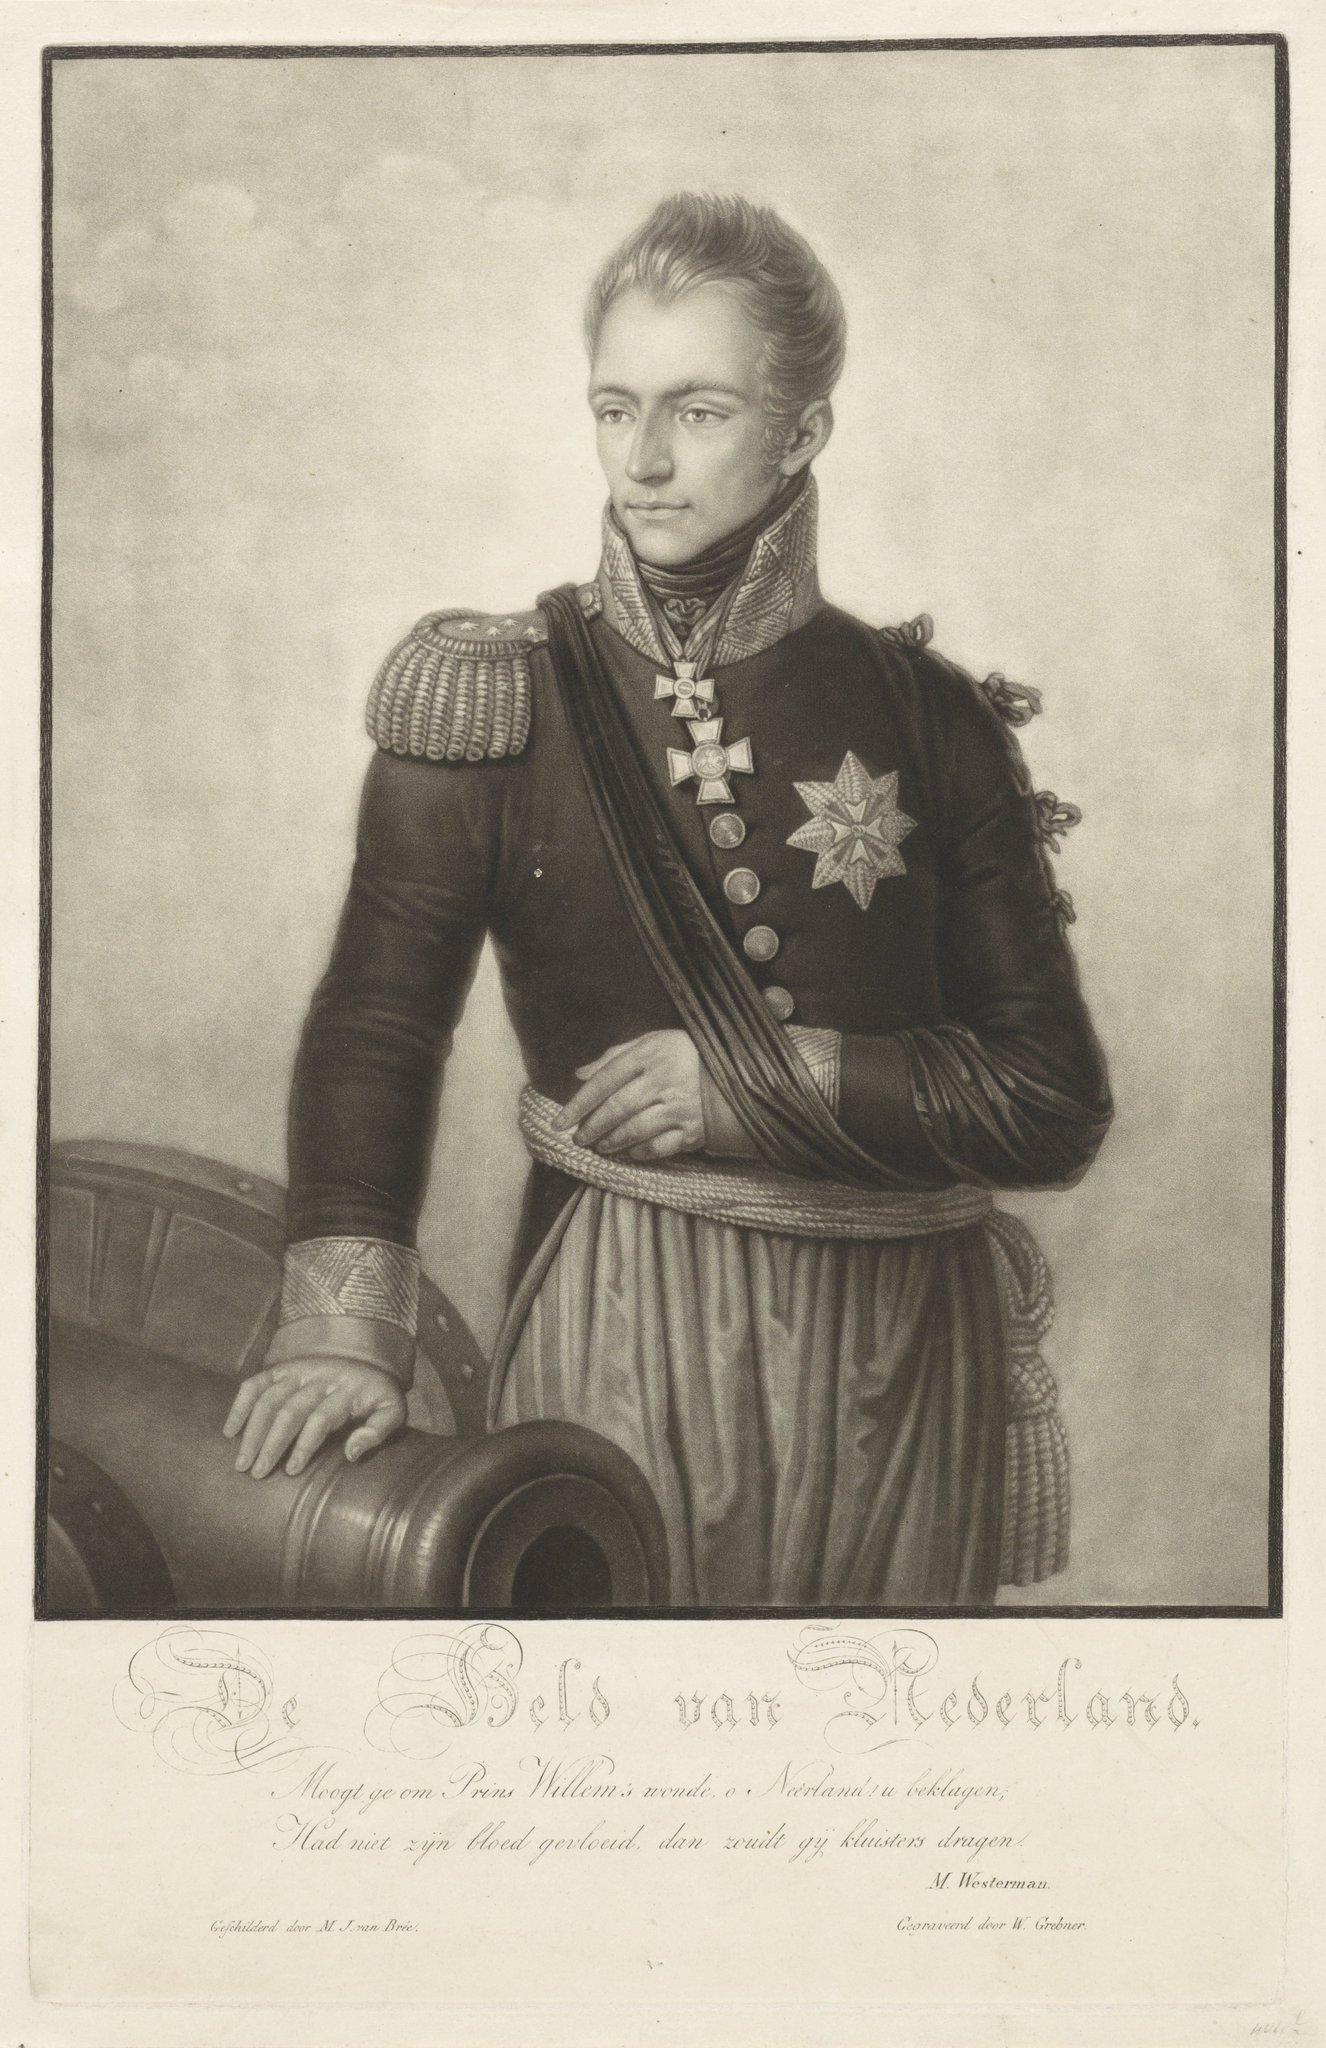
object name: print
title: Portret van koning Willem II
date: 1815-1866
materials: paper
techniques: engraving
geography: amsterdam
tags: the hague, william ii of the netherlands, firearms: cannon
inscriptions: collector's mark: Lugt 2228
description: Willem Frederik George Lodewijk, Koning Willem II als kroonprins. Hij draagt een mitella en laat zijn hand op een kanon rusten.